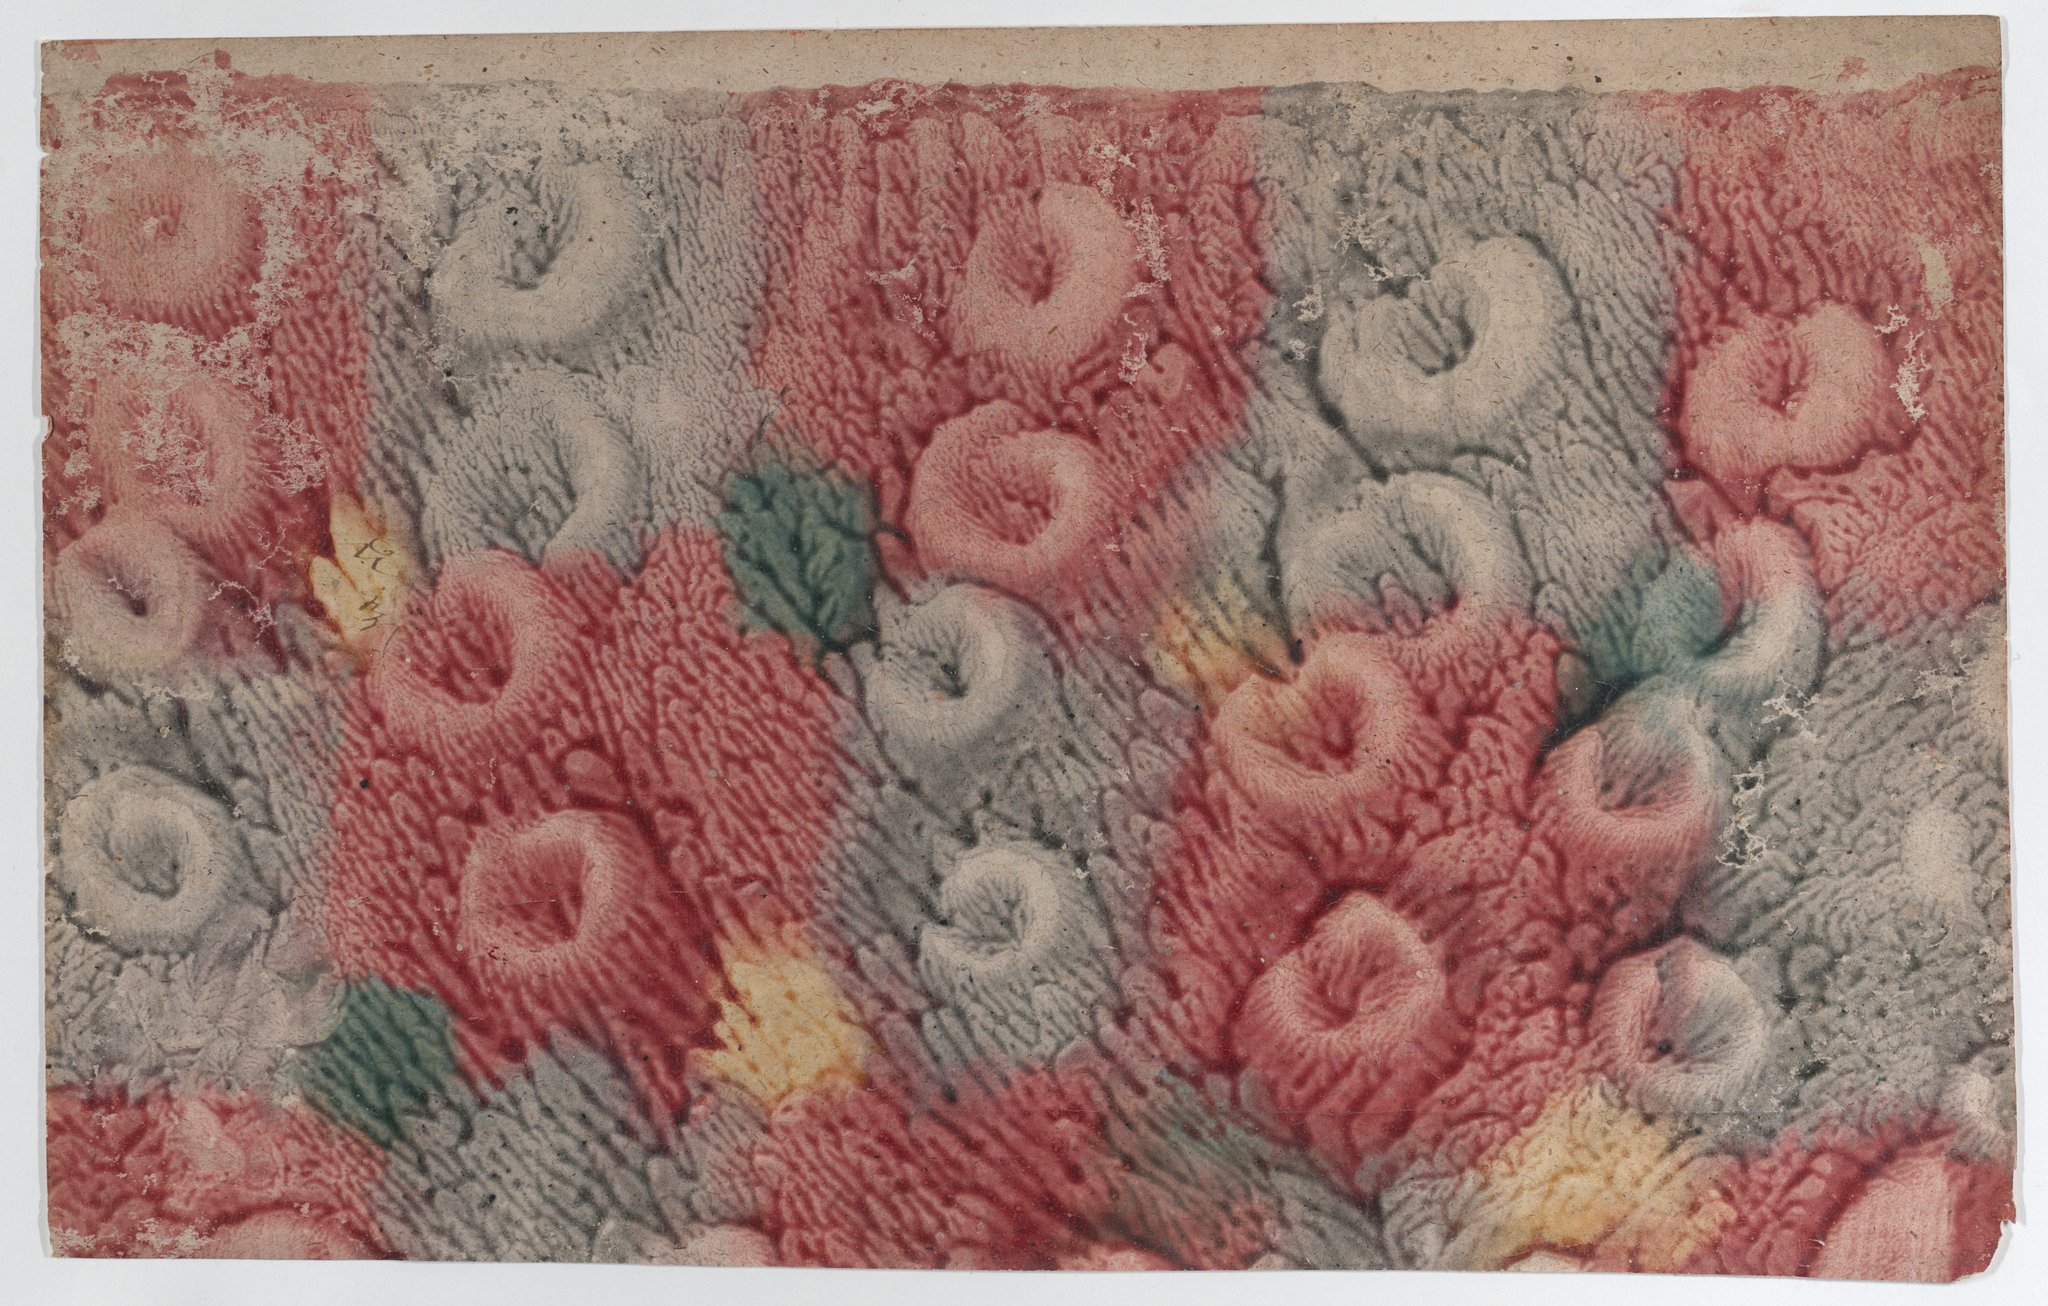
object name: print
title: Paste paper with red, yellow, and green pattern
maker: Anonymous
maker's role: artist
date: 1801-1900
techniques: relief print